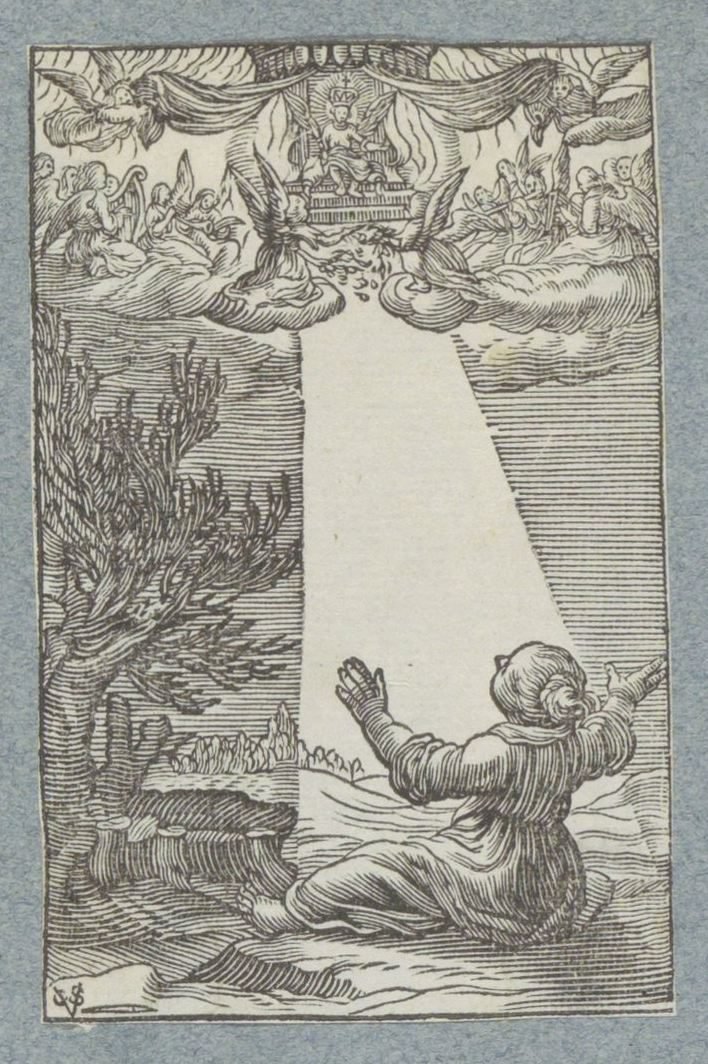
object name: album leaf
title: Pia Desideria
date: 1628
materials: paper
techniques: woodcut, pasting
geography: antwerp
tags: sitting on the ground - aa - female human figure, angels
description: Prent uit: Herman Hugo, Pia desideria emblematis, elegiis & affectibus S. S. Patrum illustrata, Antwerpen 1628. Volgens de titelpagina verscheen dit werk in Antwerpen bij Hendrick Aertssens, in werkelijkheid verscheen het in Amsterdam bij Pieter Jacobsz Paets (Dietz 2012, p. 58-59).